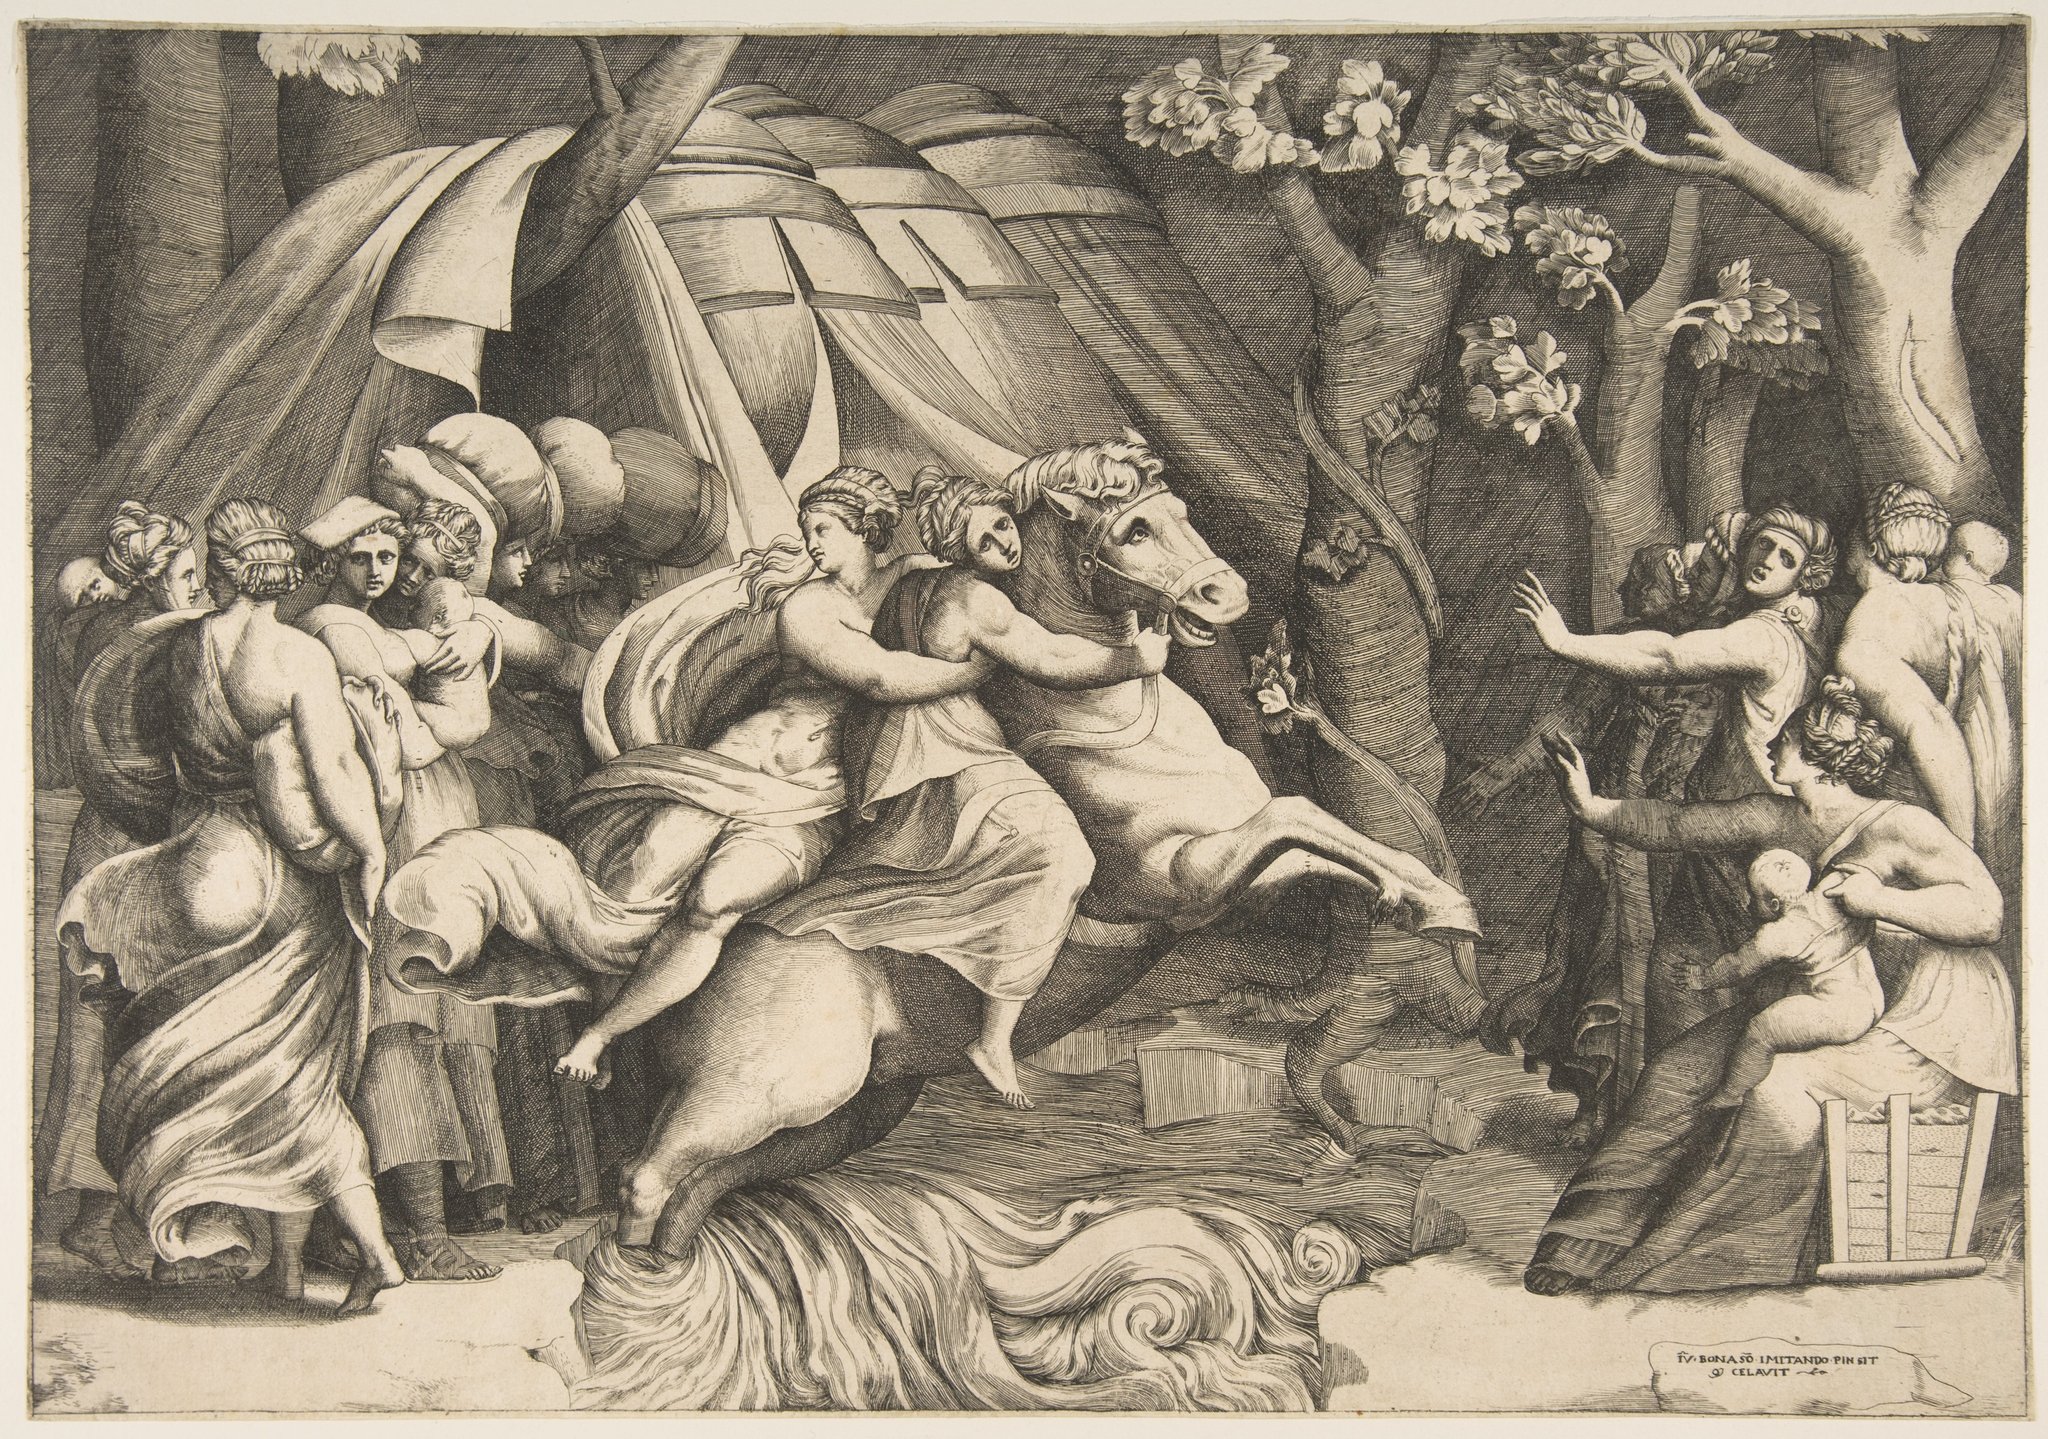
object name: print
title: Cloelia on horseback crossing the Tiber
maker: giulio bonasone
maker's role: artist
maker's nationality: italian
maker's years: 1510-1576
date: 1540-1560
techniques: engraving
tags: infants,women,horses